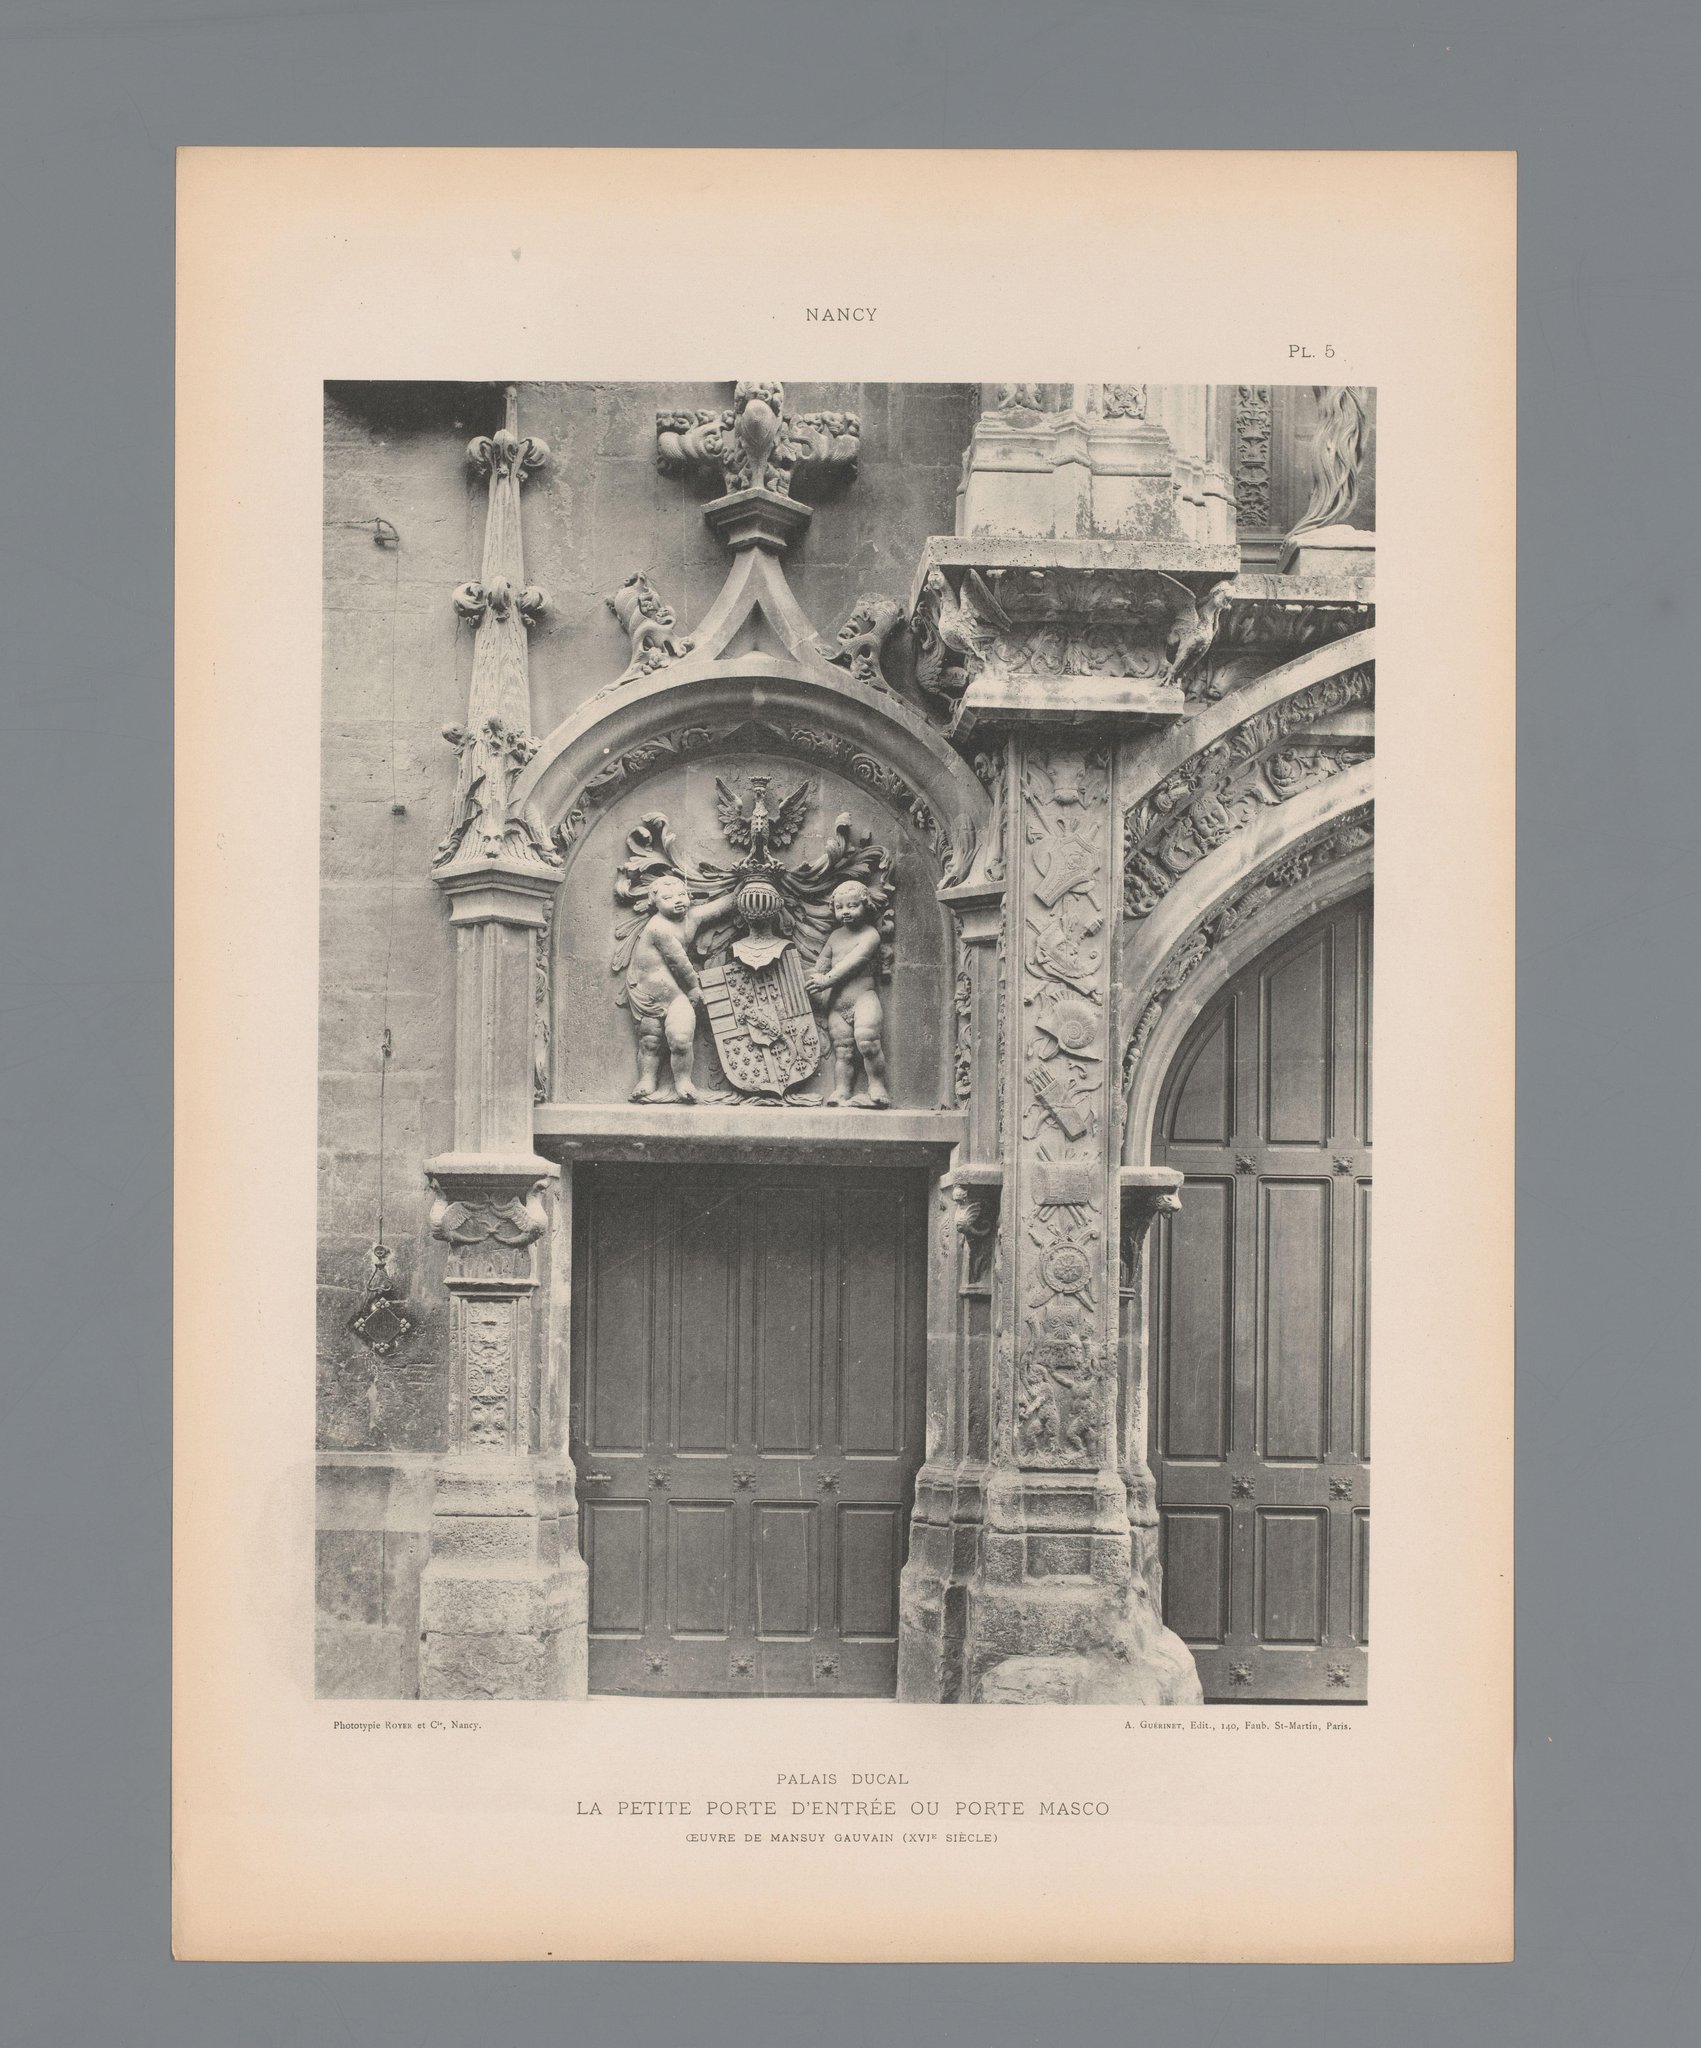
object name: photomechanical print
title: Reliëfs boven de ingang van Musée Lorrain te Nancy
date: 1891-1896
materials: paper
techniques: photograph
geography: nancy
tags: gate, entrance, sculpture (+ relief ~ sculpture)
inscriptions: inscription: ‘La petite porte d'entrée ou porte masco (...)’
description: Deze prent maakt deel uit van een omslag met 103 prenten op 101 bladen en een titelblad.